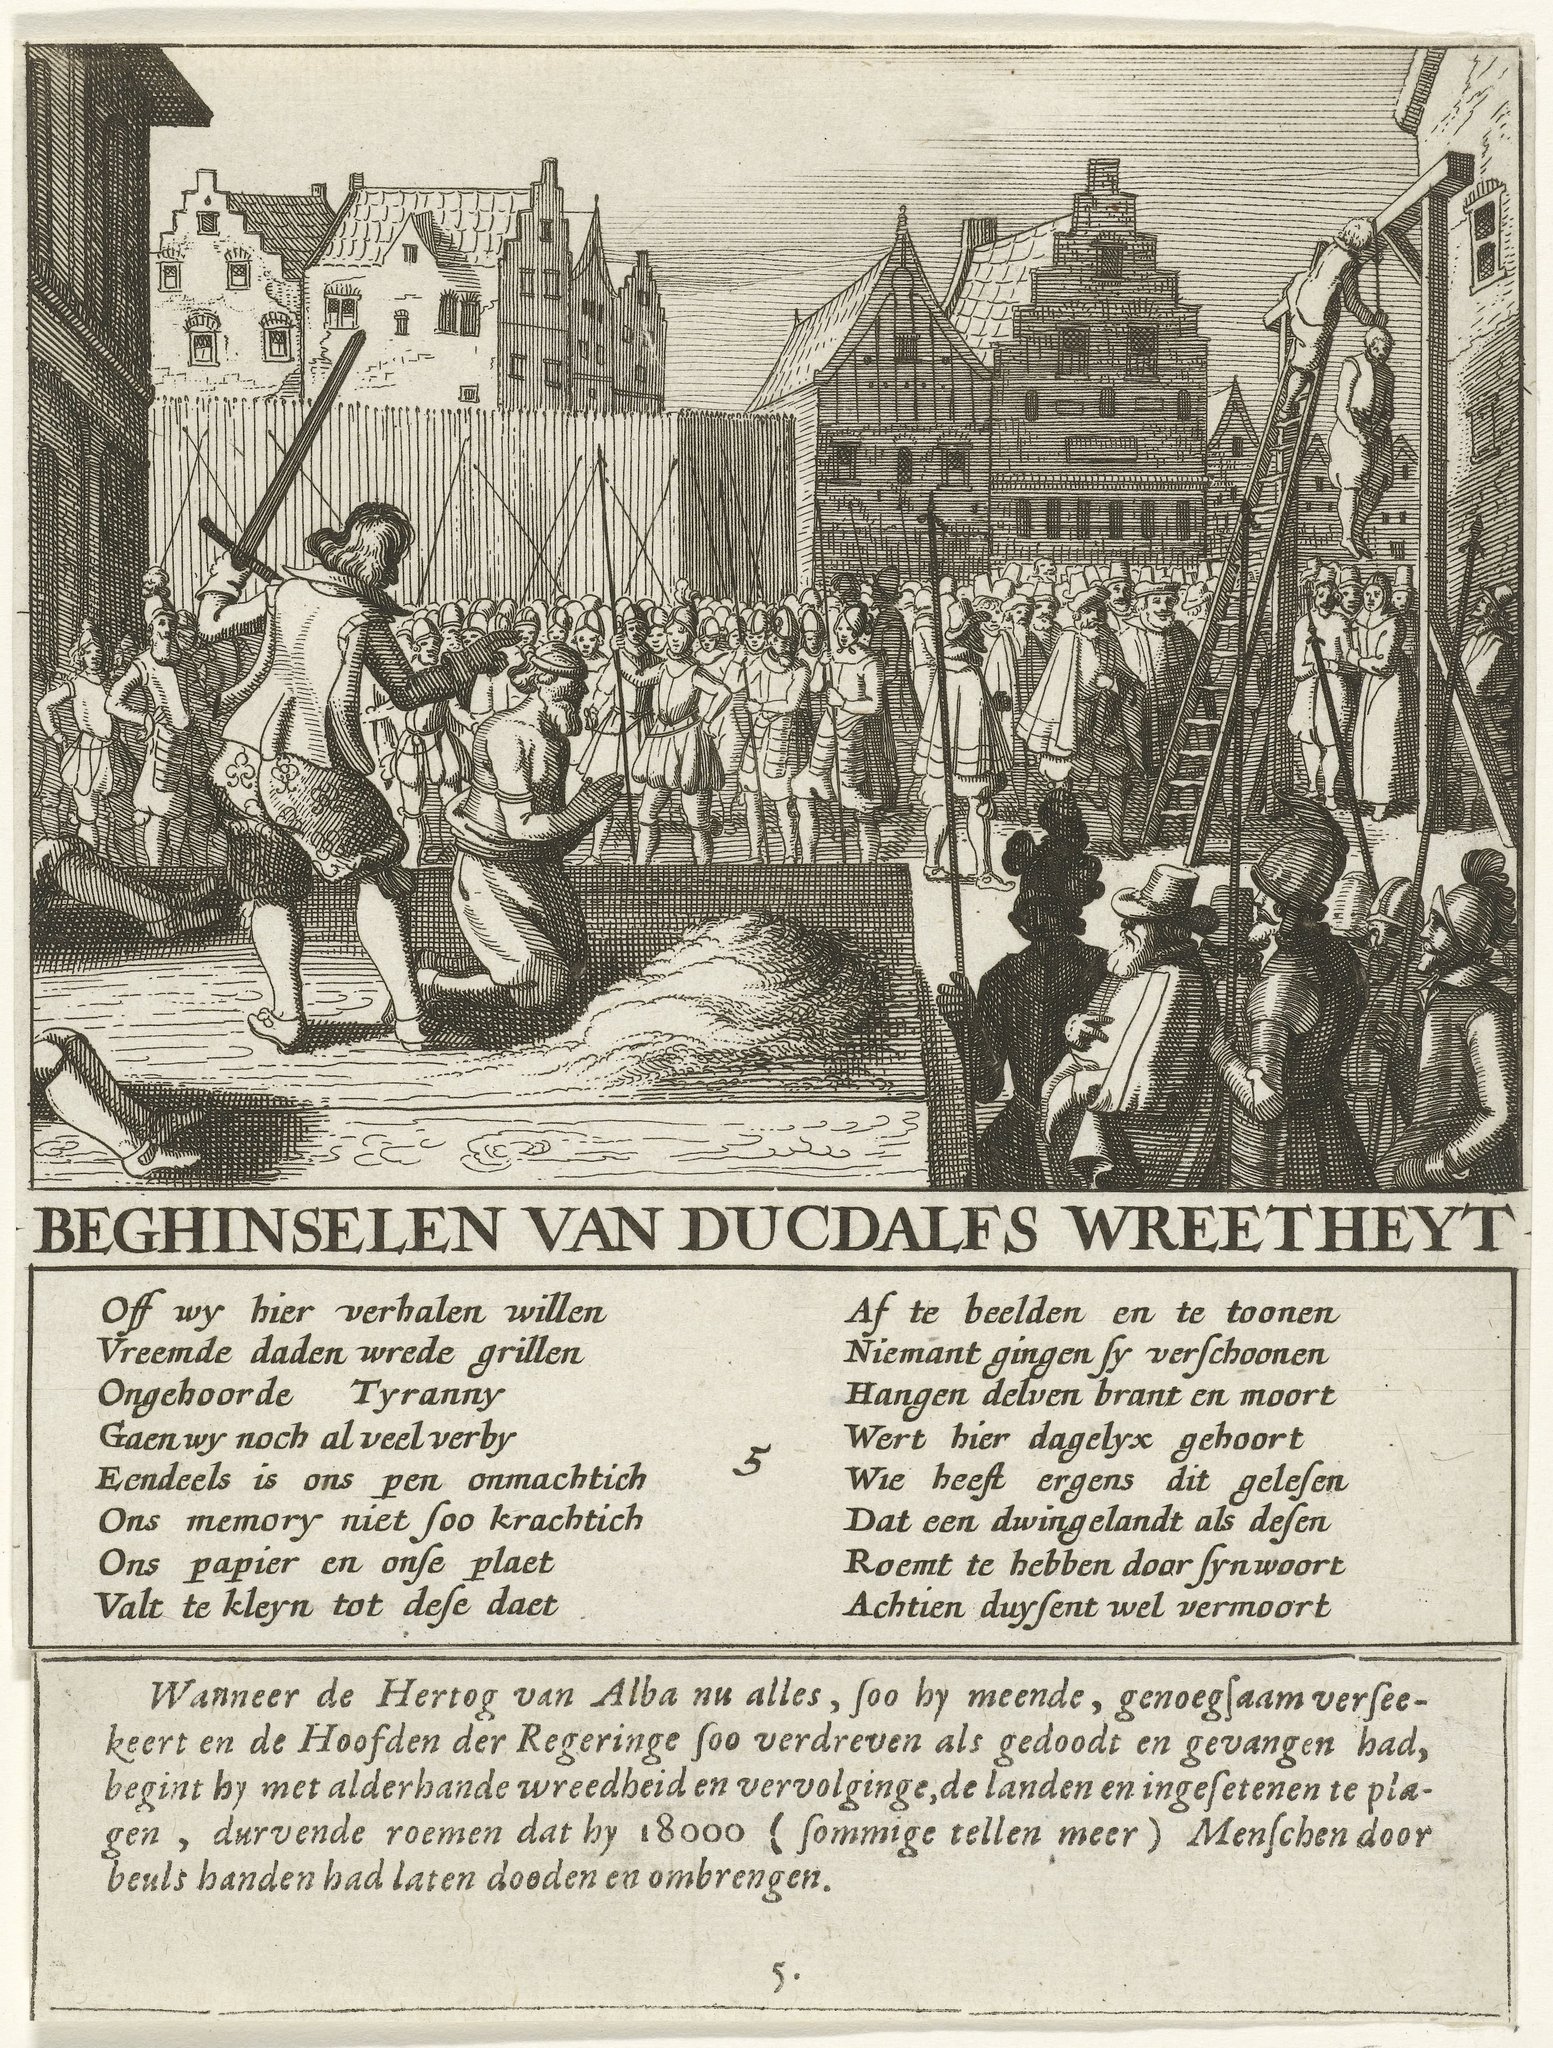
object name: history print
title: Beghinselen van Ducdalfs wreetheyt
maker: Anonymous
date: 1618-1624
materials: paper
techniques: etching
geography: northern netherlands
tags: fernando álvarez de toledo (3rd duke of alba), violent death by hanging, violent death by beheading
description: Illustratie voor een (onbekende) uitgave van het populaire en vaak herdrukte werk getiteld: De Spaensche Tiranye gheschiet in Nederlant, waarschijnlijk voor het eerst ca. 1620 verschenen. Zie ook Hollstein (Dutch), vol. XXXVIII (Claes Jansz. Visscher II), p. 165, nr. 425 en een andere versie van dit werk uitgegeven in 1621 te Amsterdam bij C.L. vander Plasse, in de collectie van de Rijksmuseum Research Library, signatuur 327 K 30.